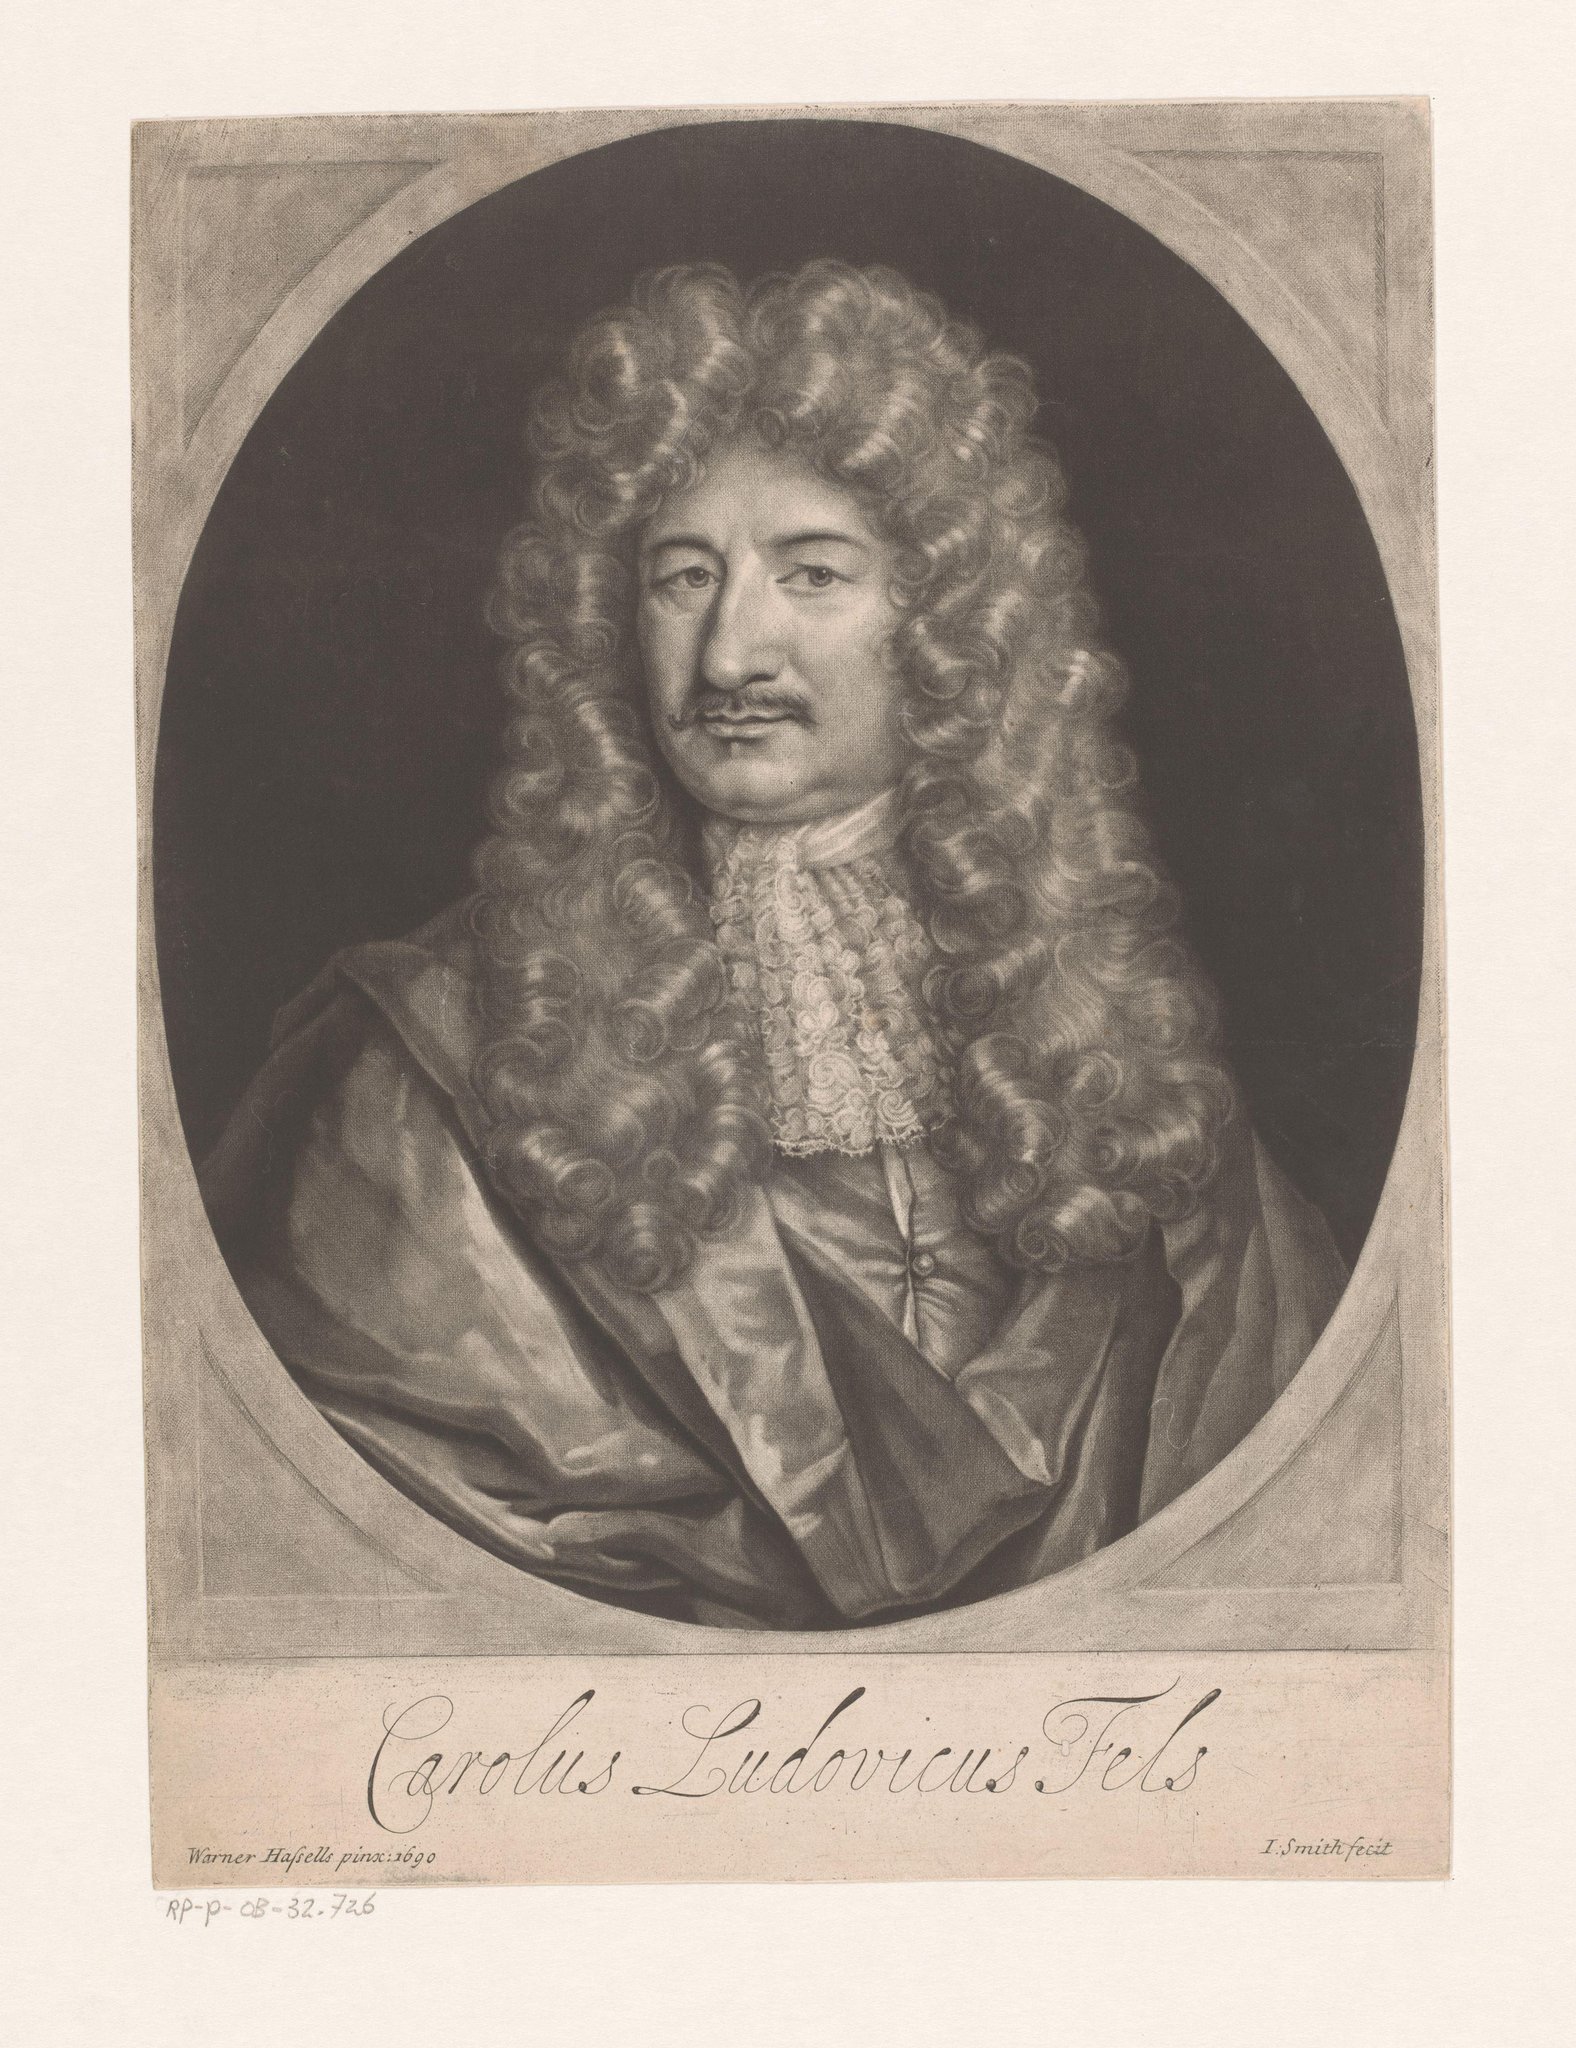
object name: print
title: Portret van Charles Louis Fels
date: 1690-1742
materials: paper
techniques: mezzotint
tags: historical persons, merchant, salesman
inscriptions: collector's mark: Lugt 240